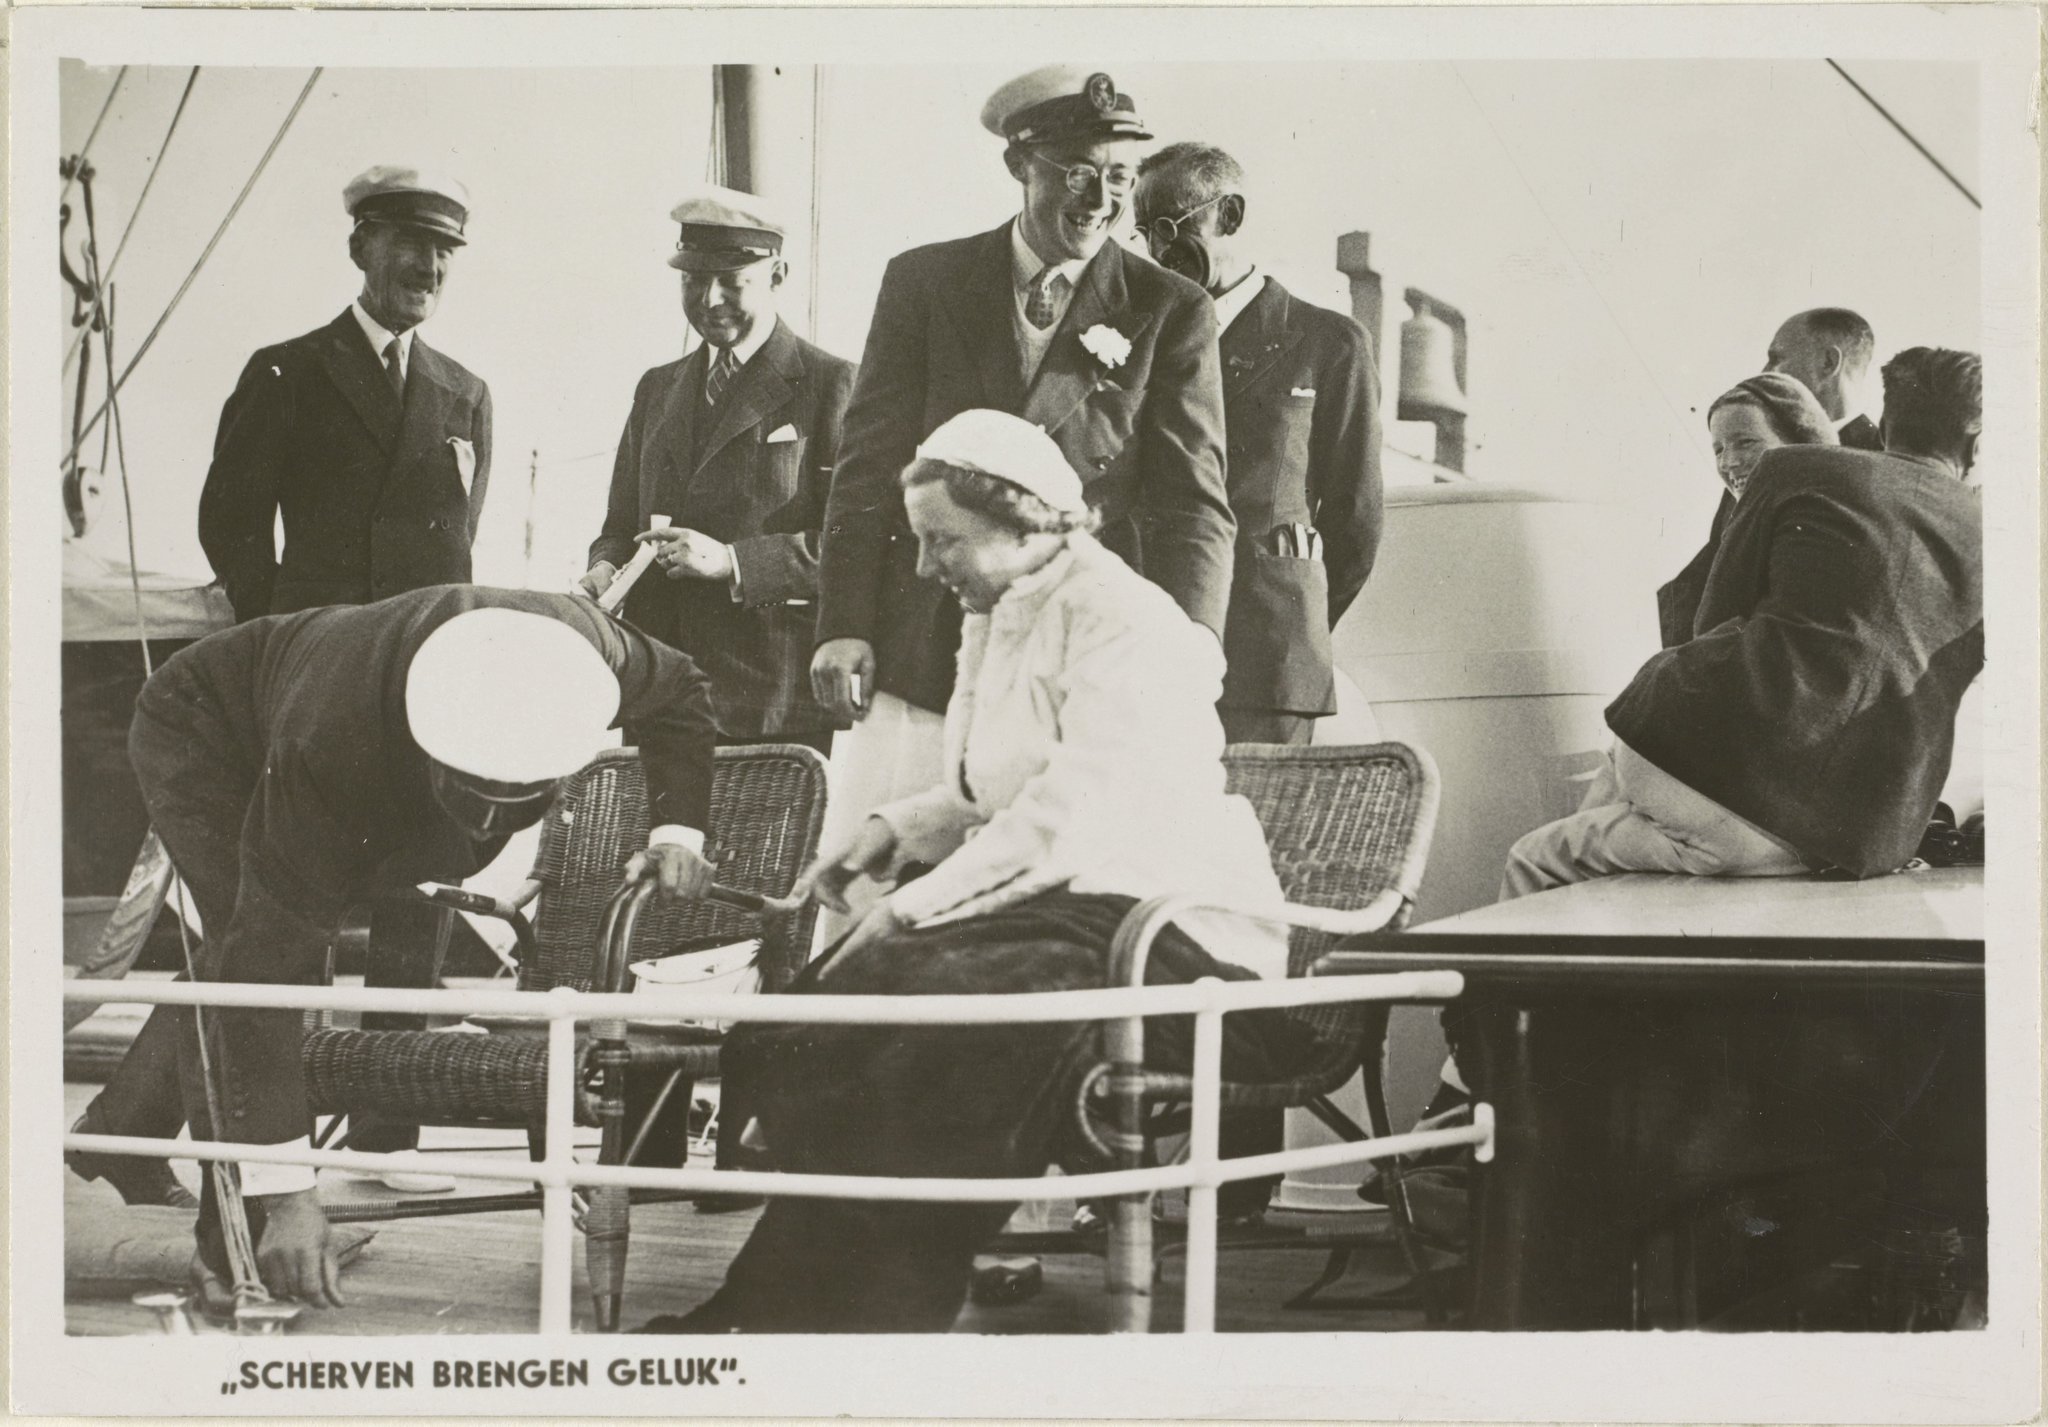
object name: photograph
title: Bezoek van Juliana, koningin der Nederlanden, en Bernhard van Lippe-Biesterfeld aan het prinsenjacht Hr. Ms. 'Piet Hein' te Muiden op 28 augustus 1937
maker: Anonymous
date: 1937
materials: photographic support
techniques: photography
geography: amsterdam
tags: utrecht, bernhard (prins der nederlanden), the hague, juliana of the netherlands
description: De hier vermelde titel verwijst naar de hoogst verkregen titel van de geportretteerde, niet per se naar de titel die de geportretteerde op deze voorstelling draagt.